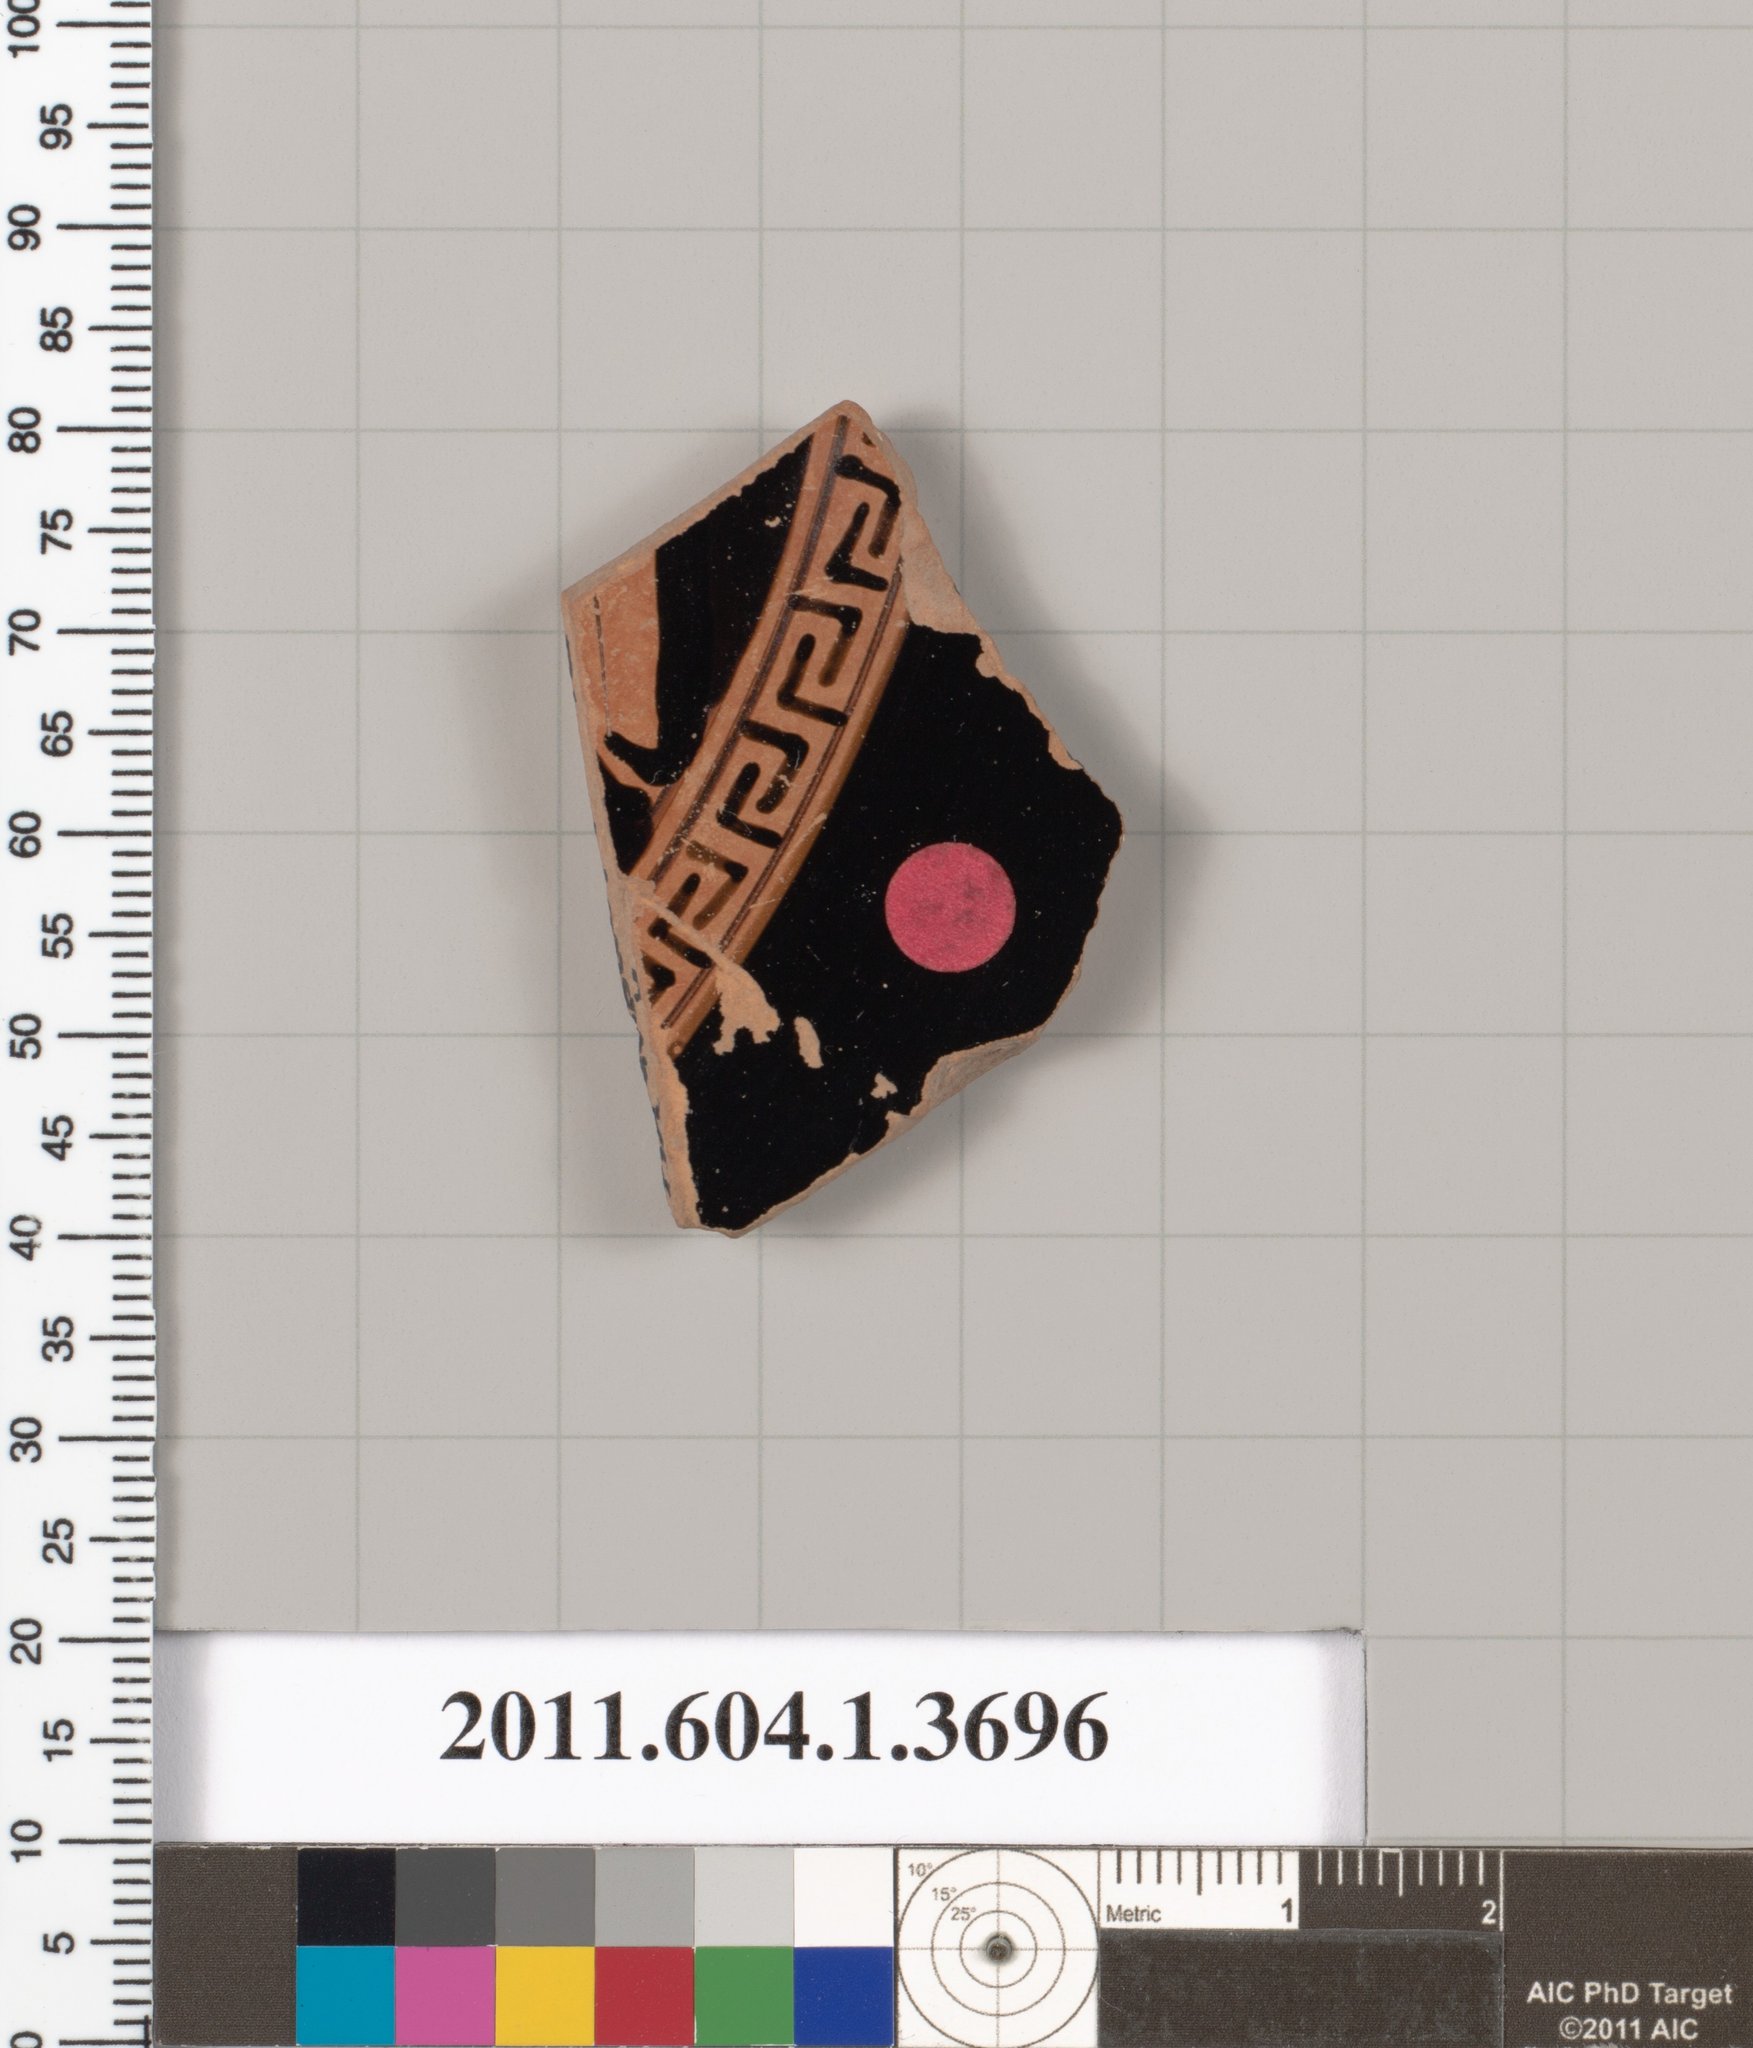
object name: kylix fragment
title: Terracotta fragment of a kylix (drinking cup)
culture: greek, attic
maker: painter of london d 12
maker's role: artist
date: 475-451 BCE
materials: terracotta